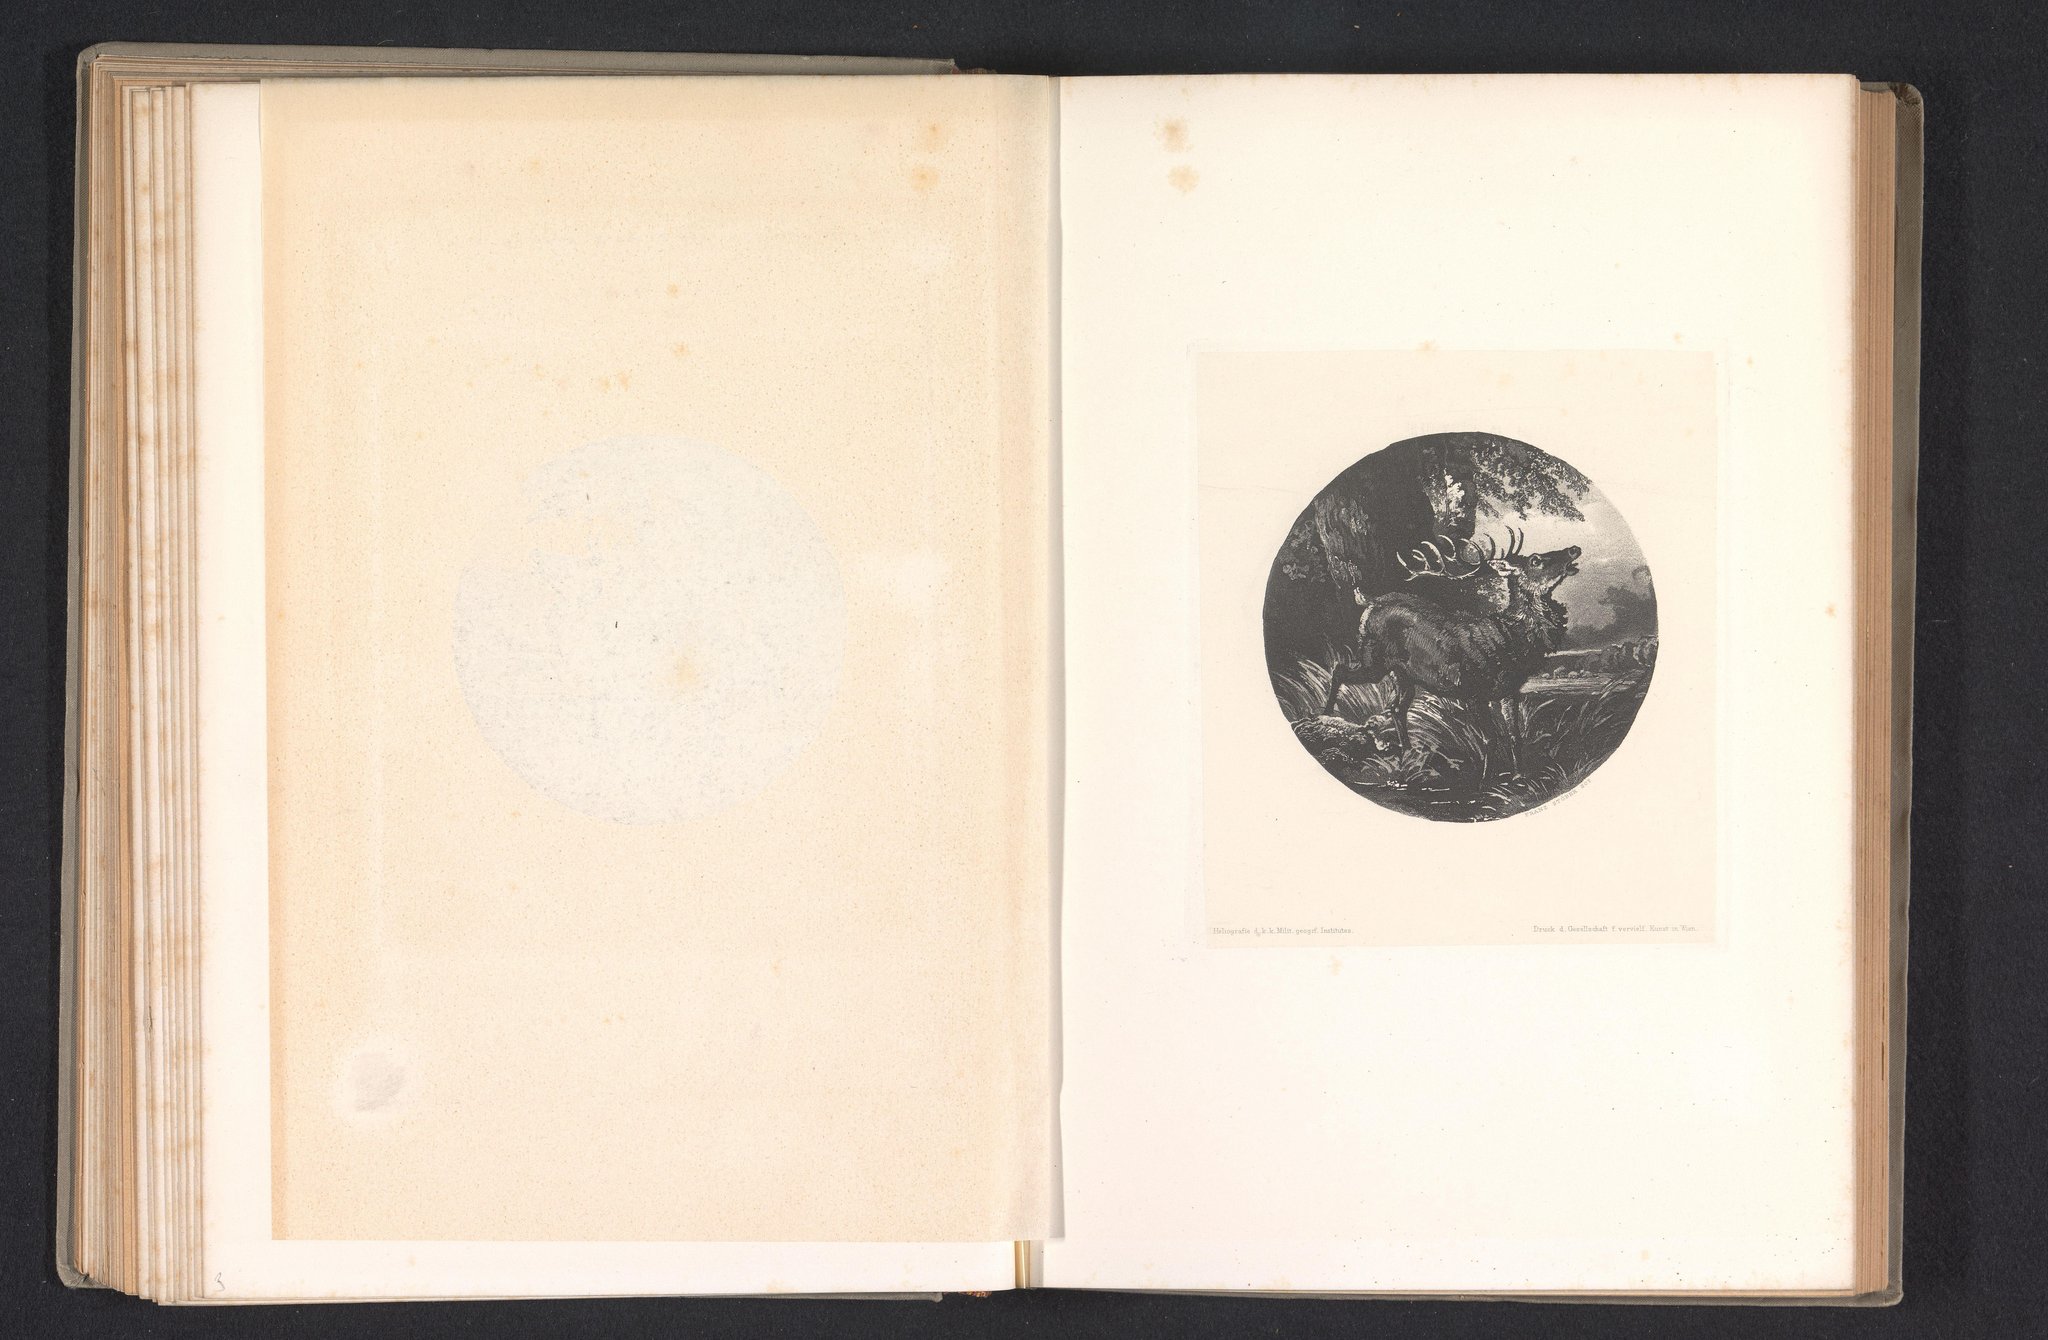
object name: page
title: Fotoreproductie van een prent, voorstellende een hert in een boslandschap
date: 1878-1883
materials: paper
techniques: photoaquatint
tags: hoofed animals: deer, forest, wood